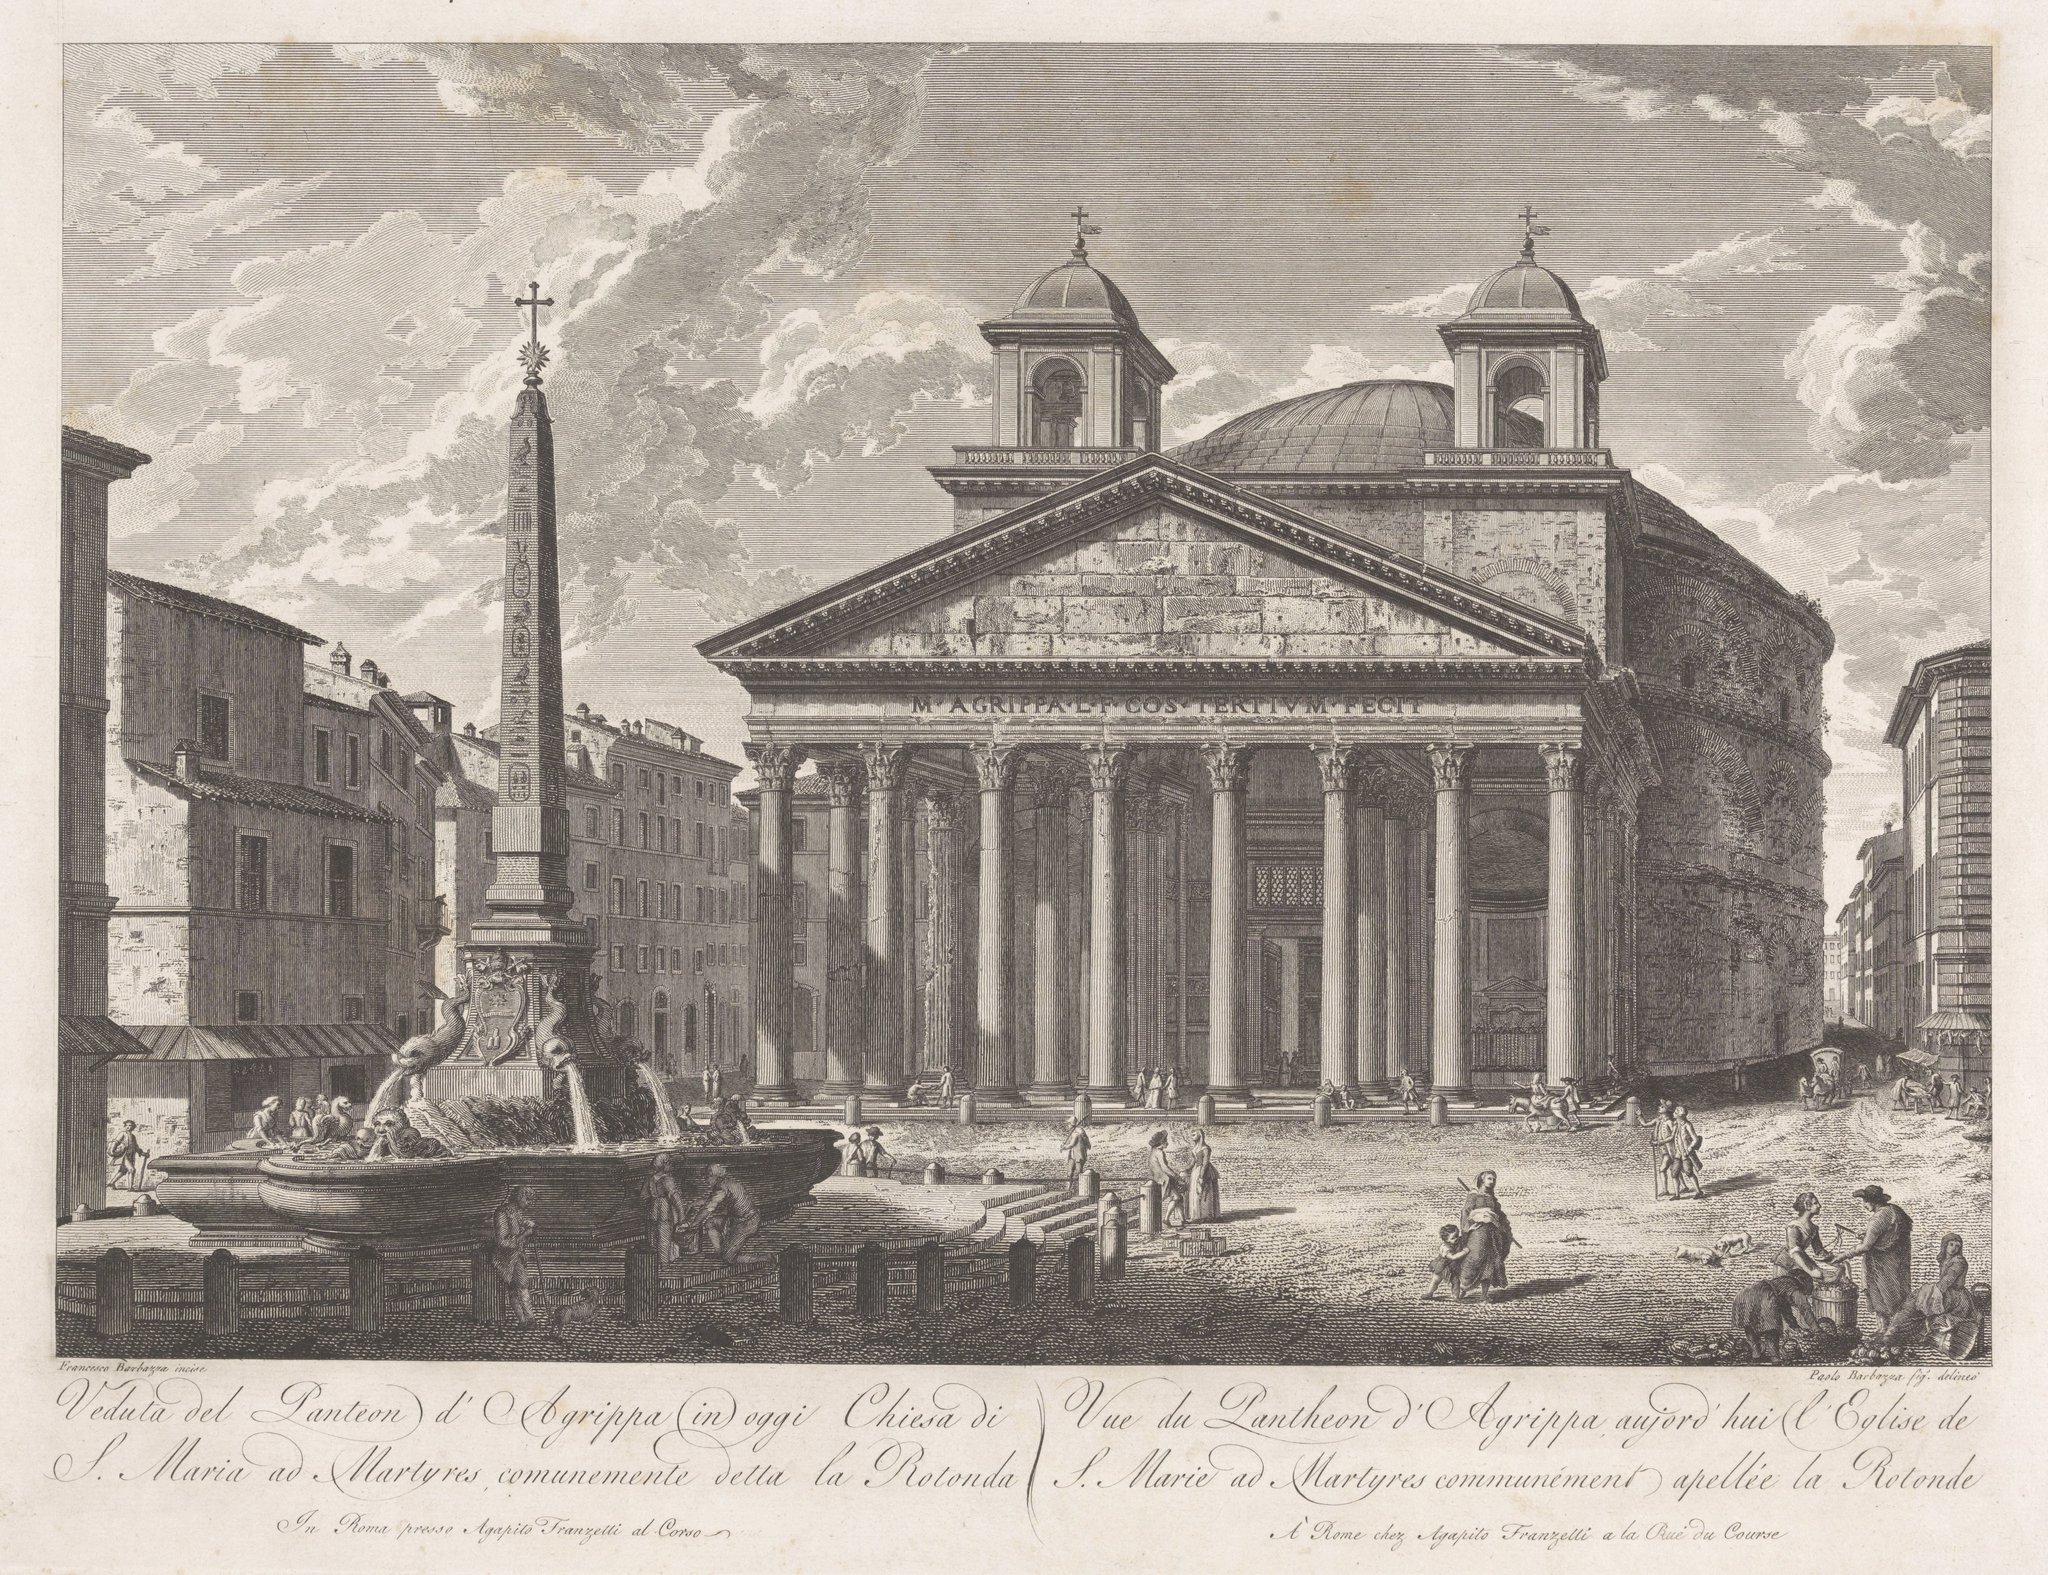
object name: print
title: Veduta del Panteon d'Agrippa in oggi chiesa di S. Maria ad Martyres comunemente detta la Rotonda (...)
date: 1775-1785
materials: paper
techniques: engraving, etching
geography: rome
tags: church (exterior), ornamental fountain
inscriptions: collector's mark: Lugt 2228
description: Zicht op het Piazza della Rotonda in Rome met het Pantheon en de Fontana del Pantheon. Titel in de ondermarge in het Italiaans en in het Frans.